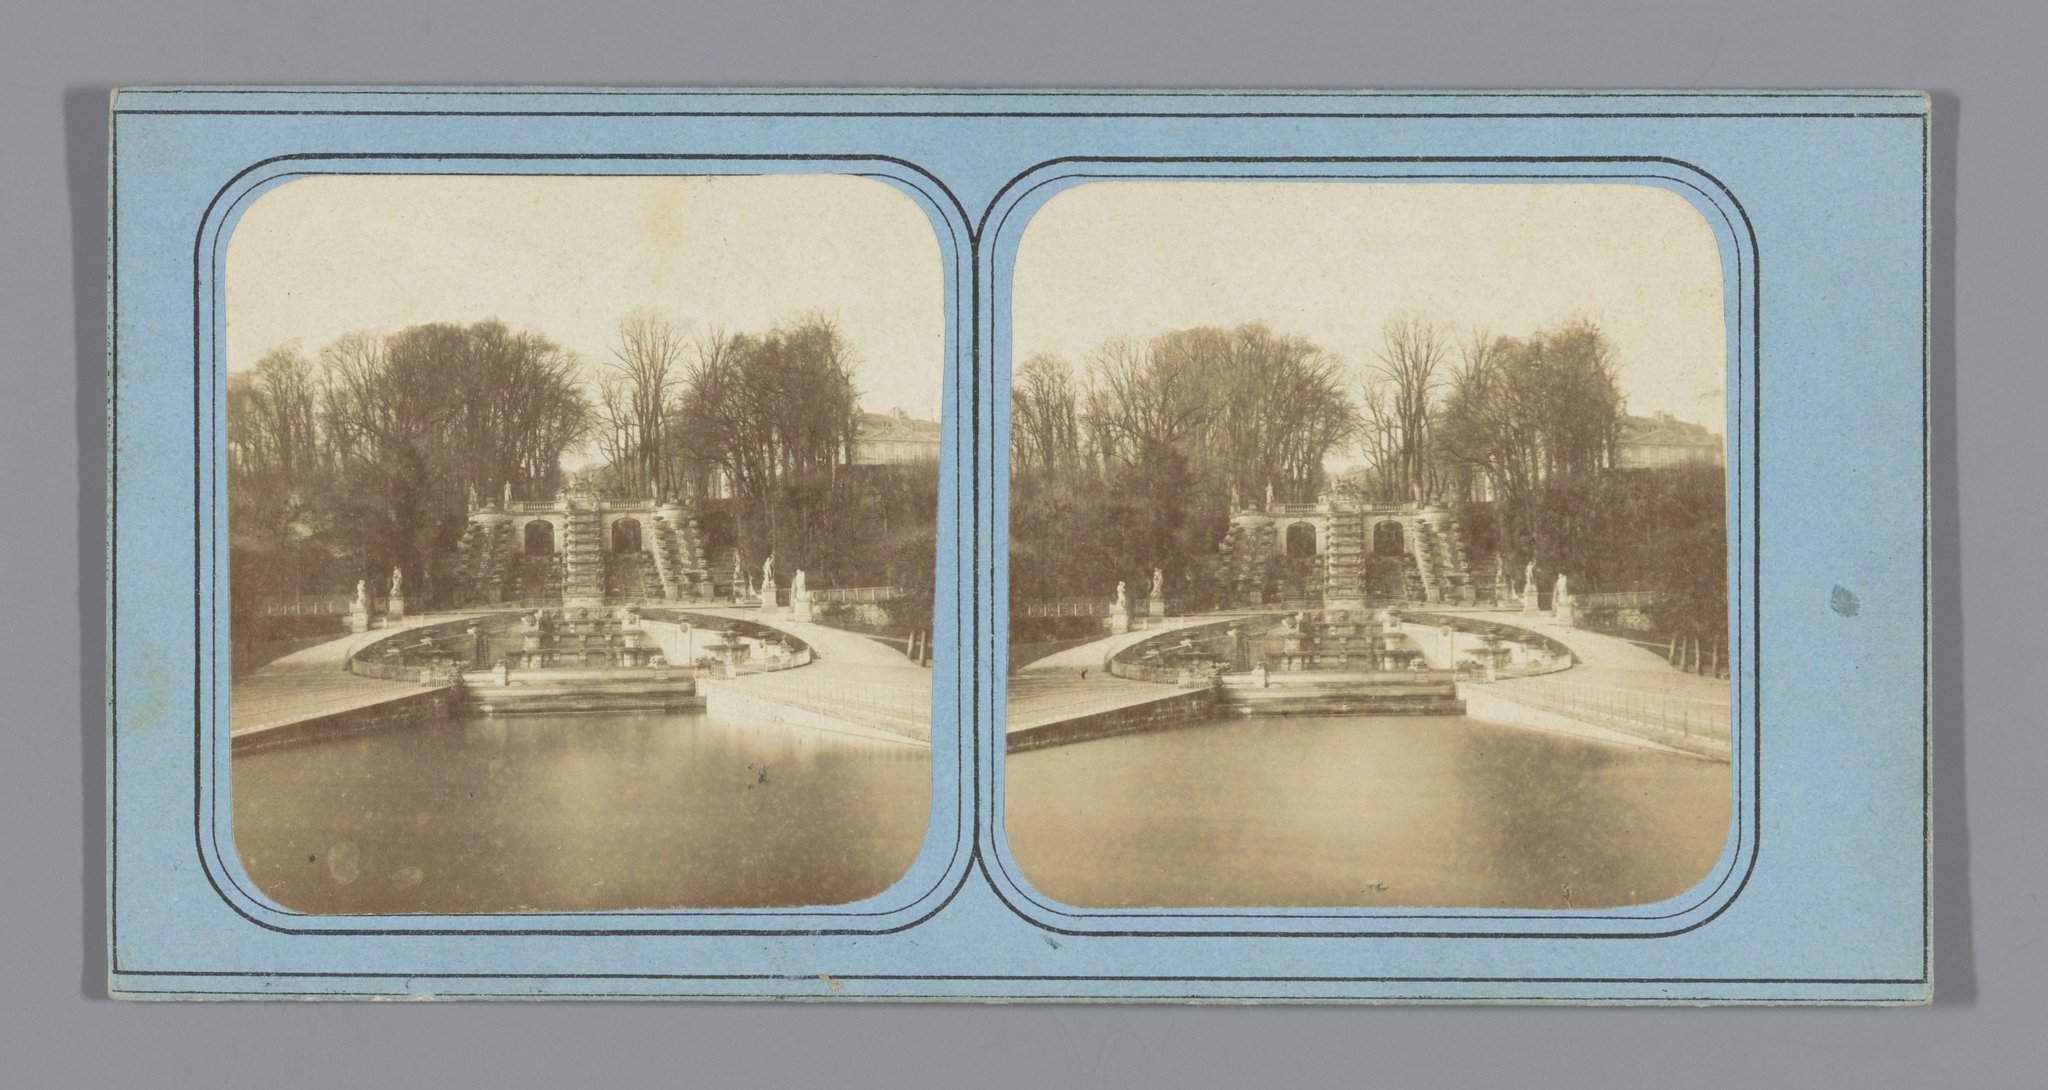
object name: stereograph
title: Watervallen in de tuin van het Kasteel van Saint-Cloud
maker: Anonymous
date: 1850-1870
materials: cardboard, photographic support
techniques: albumen print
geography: saint-cloud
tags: garden cascade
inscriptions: number: ‘No 35’, inscription: ‘Cascade de St Cloud’